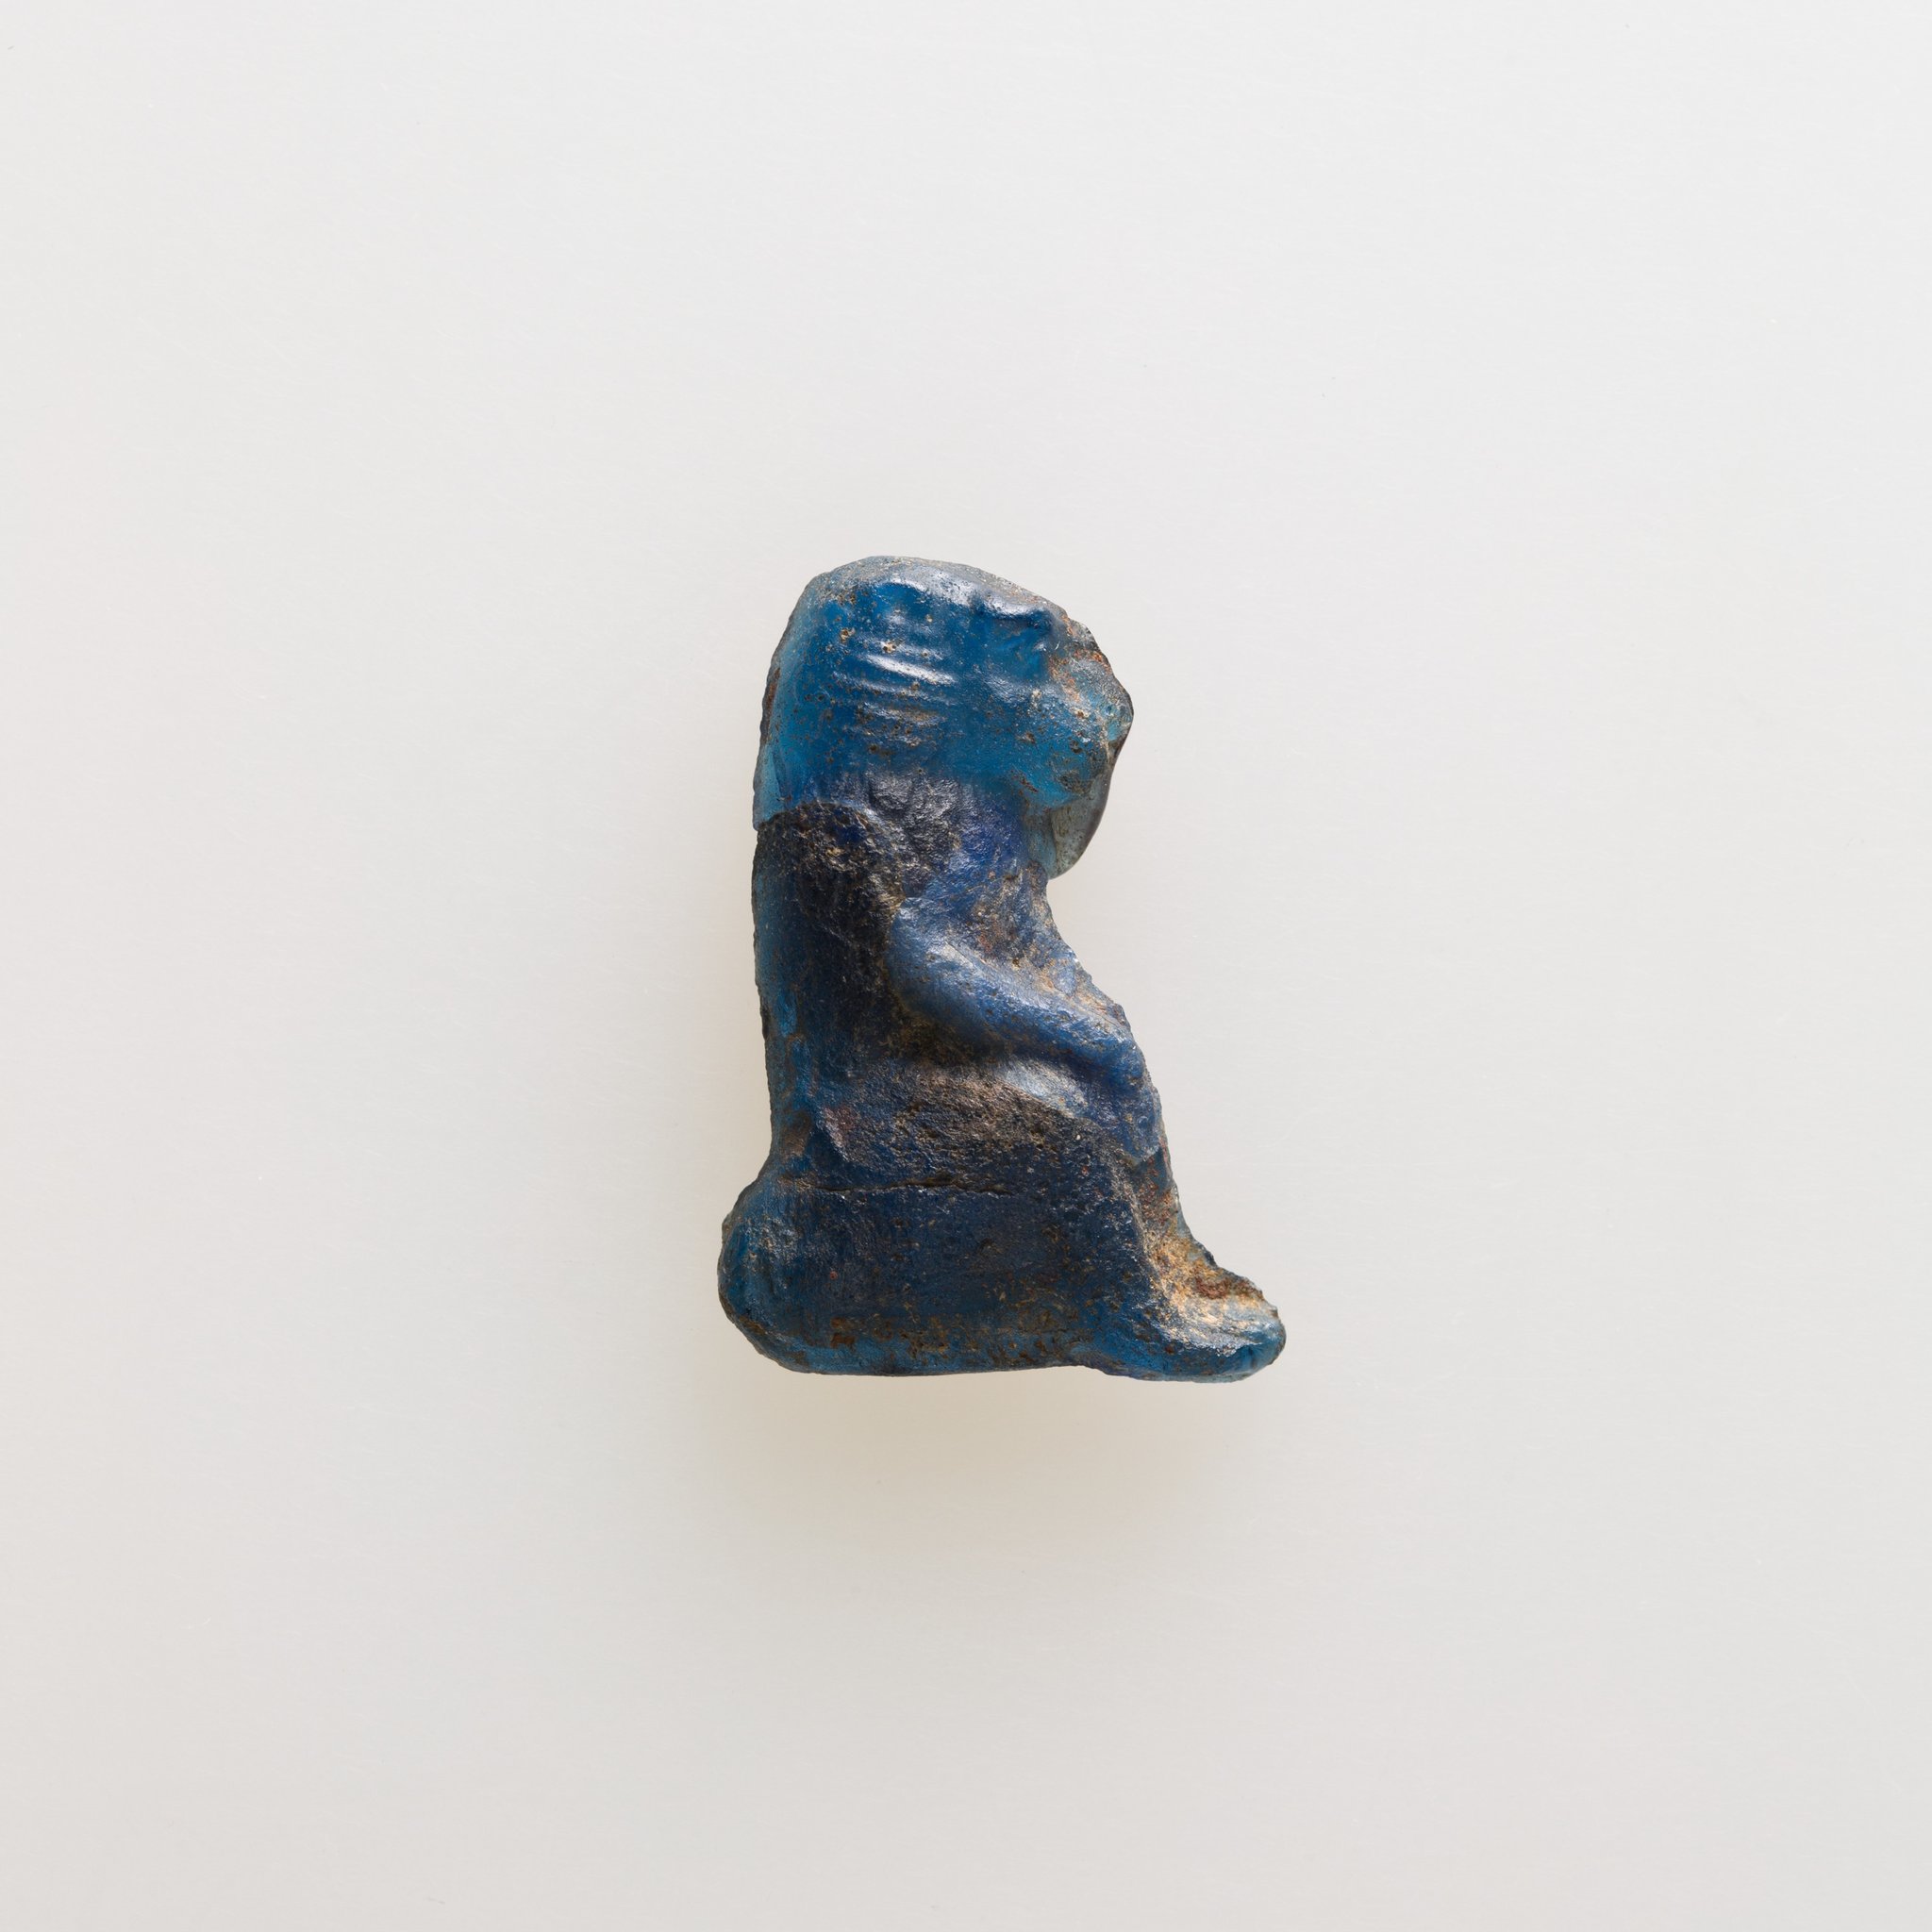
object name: amulet, baboon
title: Amulet of squatting baboon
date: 525-30 BCE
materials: glass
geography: egypt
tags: baboons